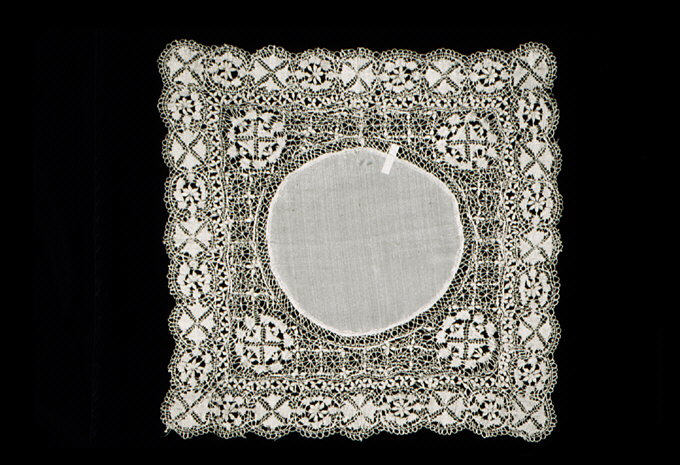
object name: handkerchief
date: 1801-1900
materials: lace, silk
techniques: lace